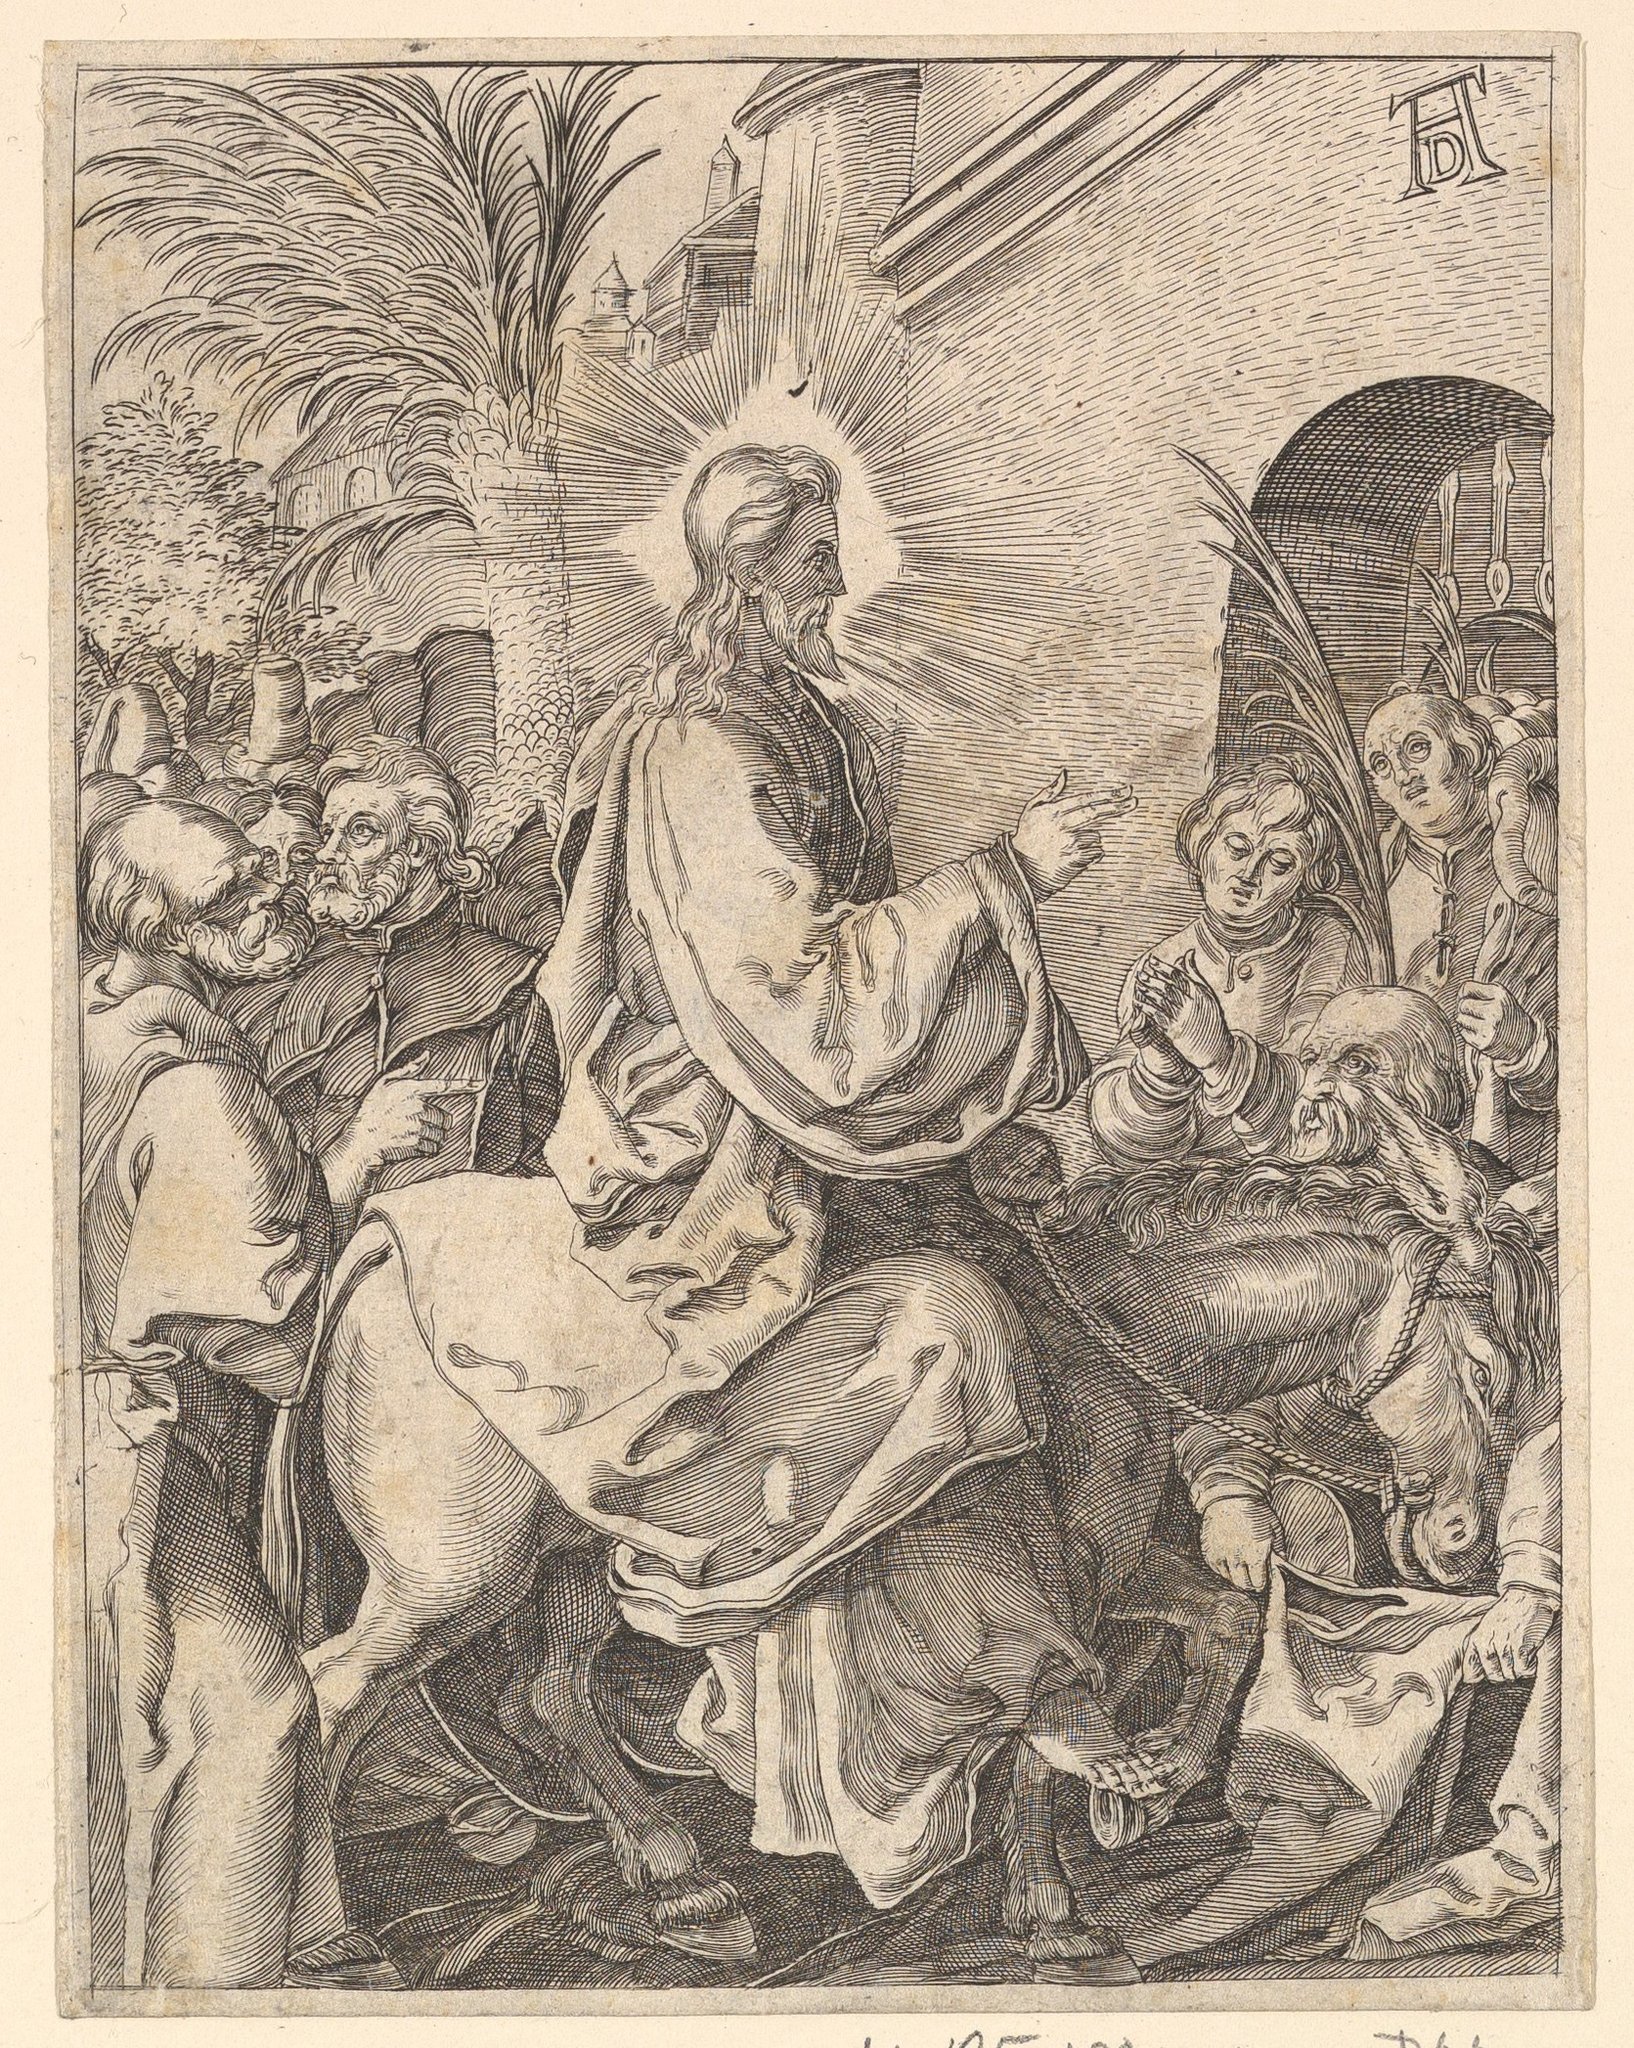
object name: print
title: Engraved copies of The Little Passion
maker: albrecht dürer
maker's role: artist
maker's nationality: german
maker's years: 1471-1528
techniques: engraving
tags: animals,men,christ